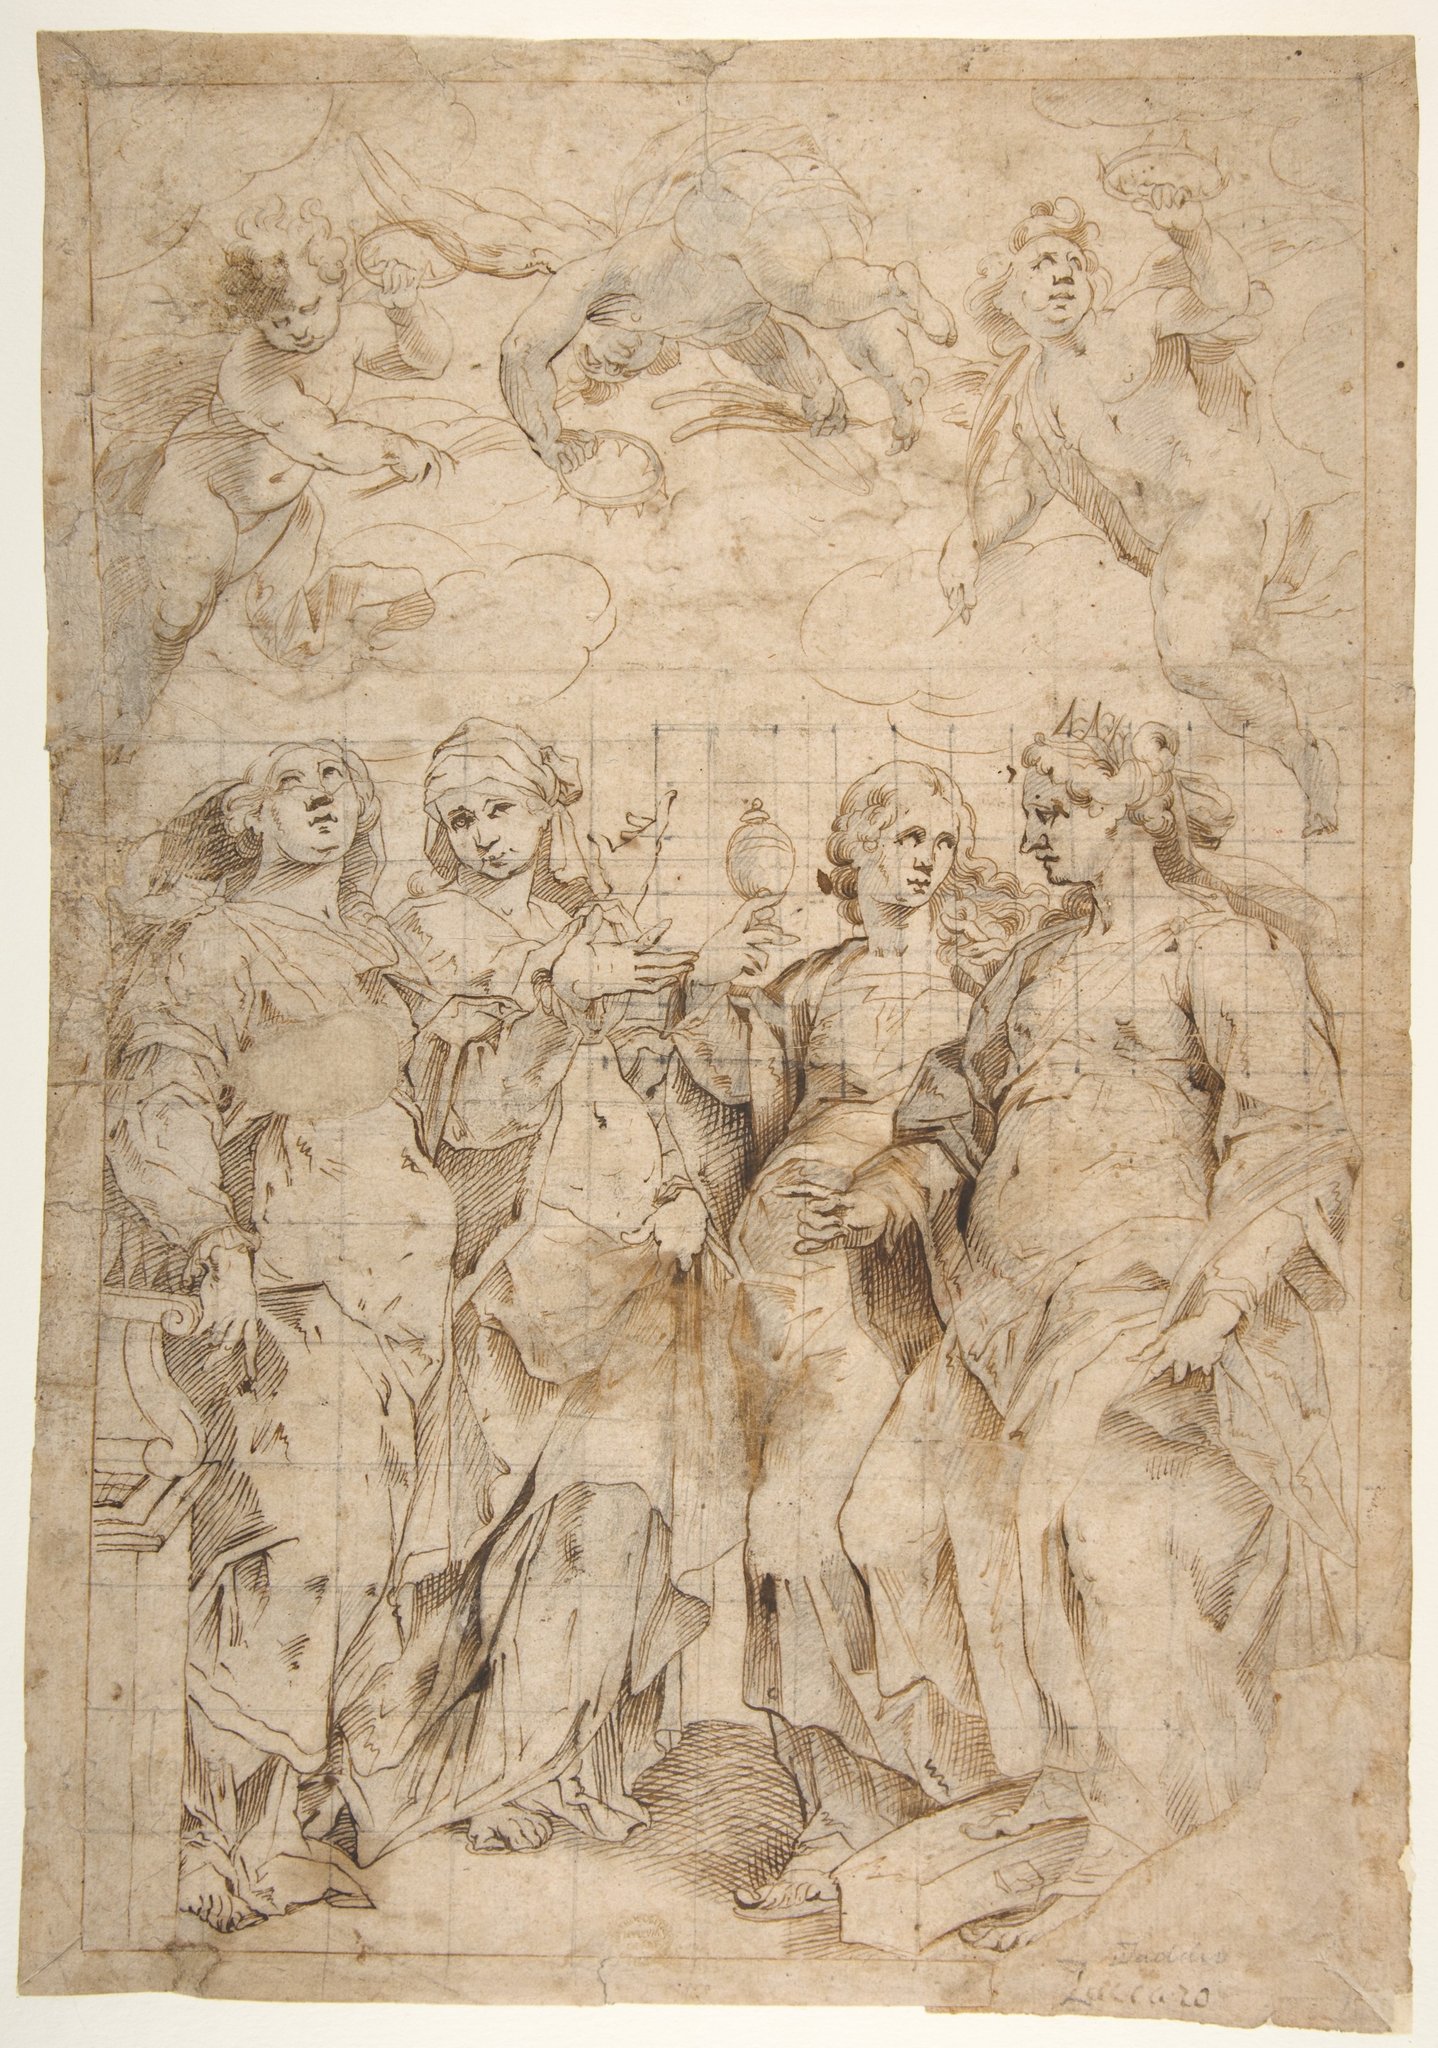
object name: drawing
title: Saint Cecilia, Saint Mary Magdalen, Saint Catherine of Alexandria, and Saint Agnes, Angels with Palm Branches and Crowns Above (recto); Sketches of Three Standing Figures and Arithmetic Calculations (verso)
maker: panfilo nuvolone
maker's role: artist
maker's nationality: italian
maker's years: 1578-1651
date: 1609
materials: chalk, ink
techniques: pen, drawing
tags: women,angels,mary magdalene,saint catherine,saints